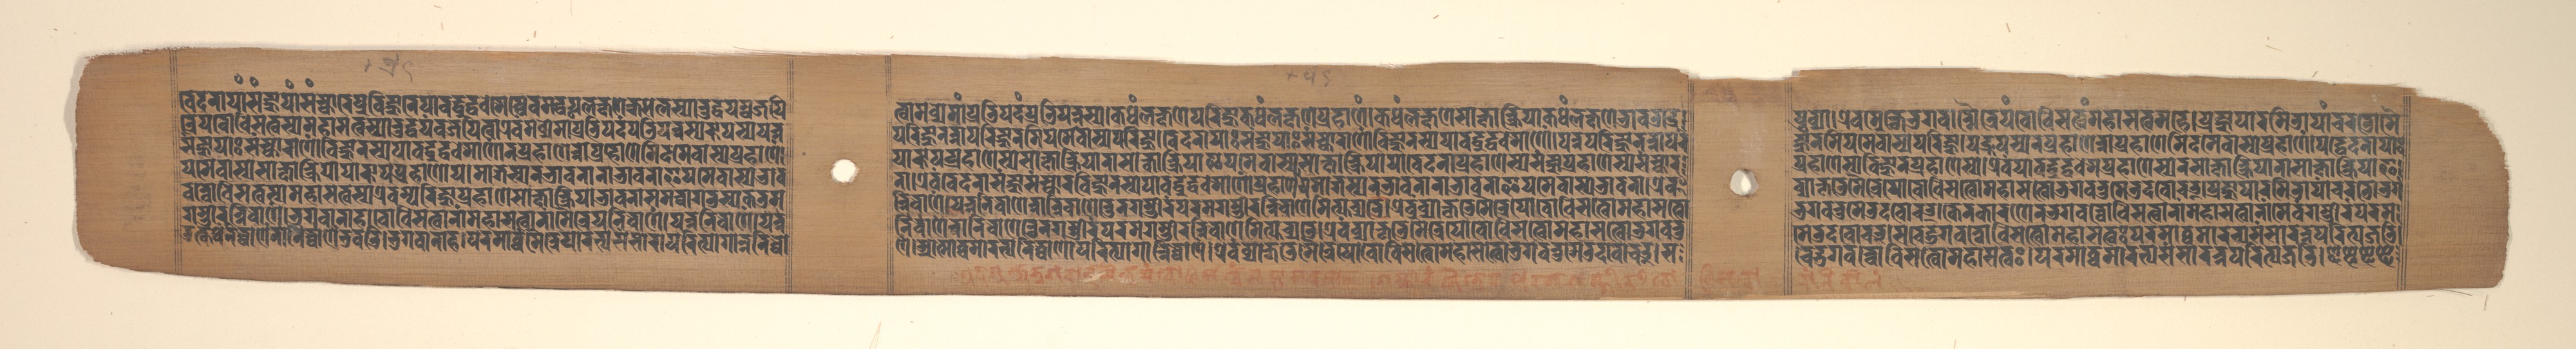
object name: folio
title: Folio from a Buddhist Manuscript of Pancavimsatisahasrika Prajnaparamita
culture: indian, bengal or bangladesh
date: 1090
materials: leaf, watercolor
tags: buddhism